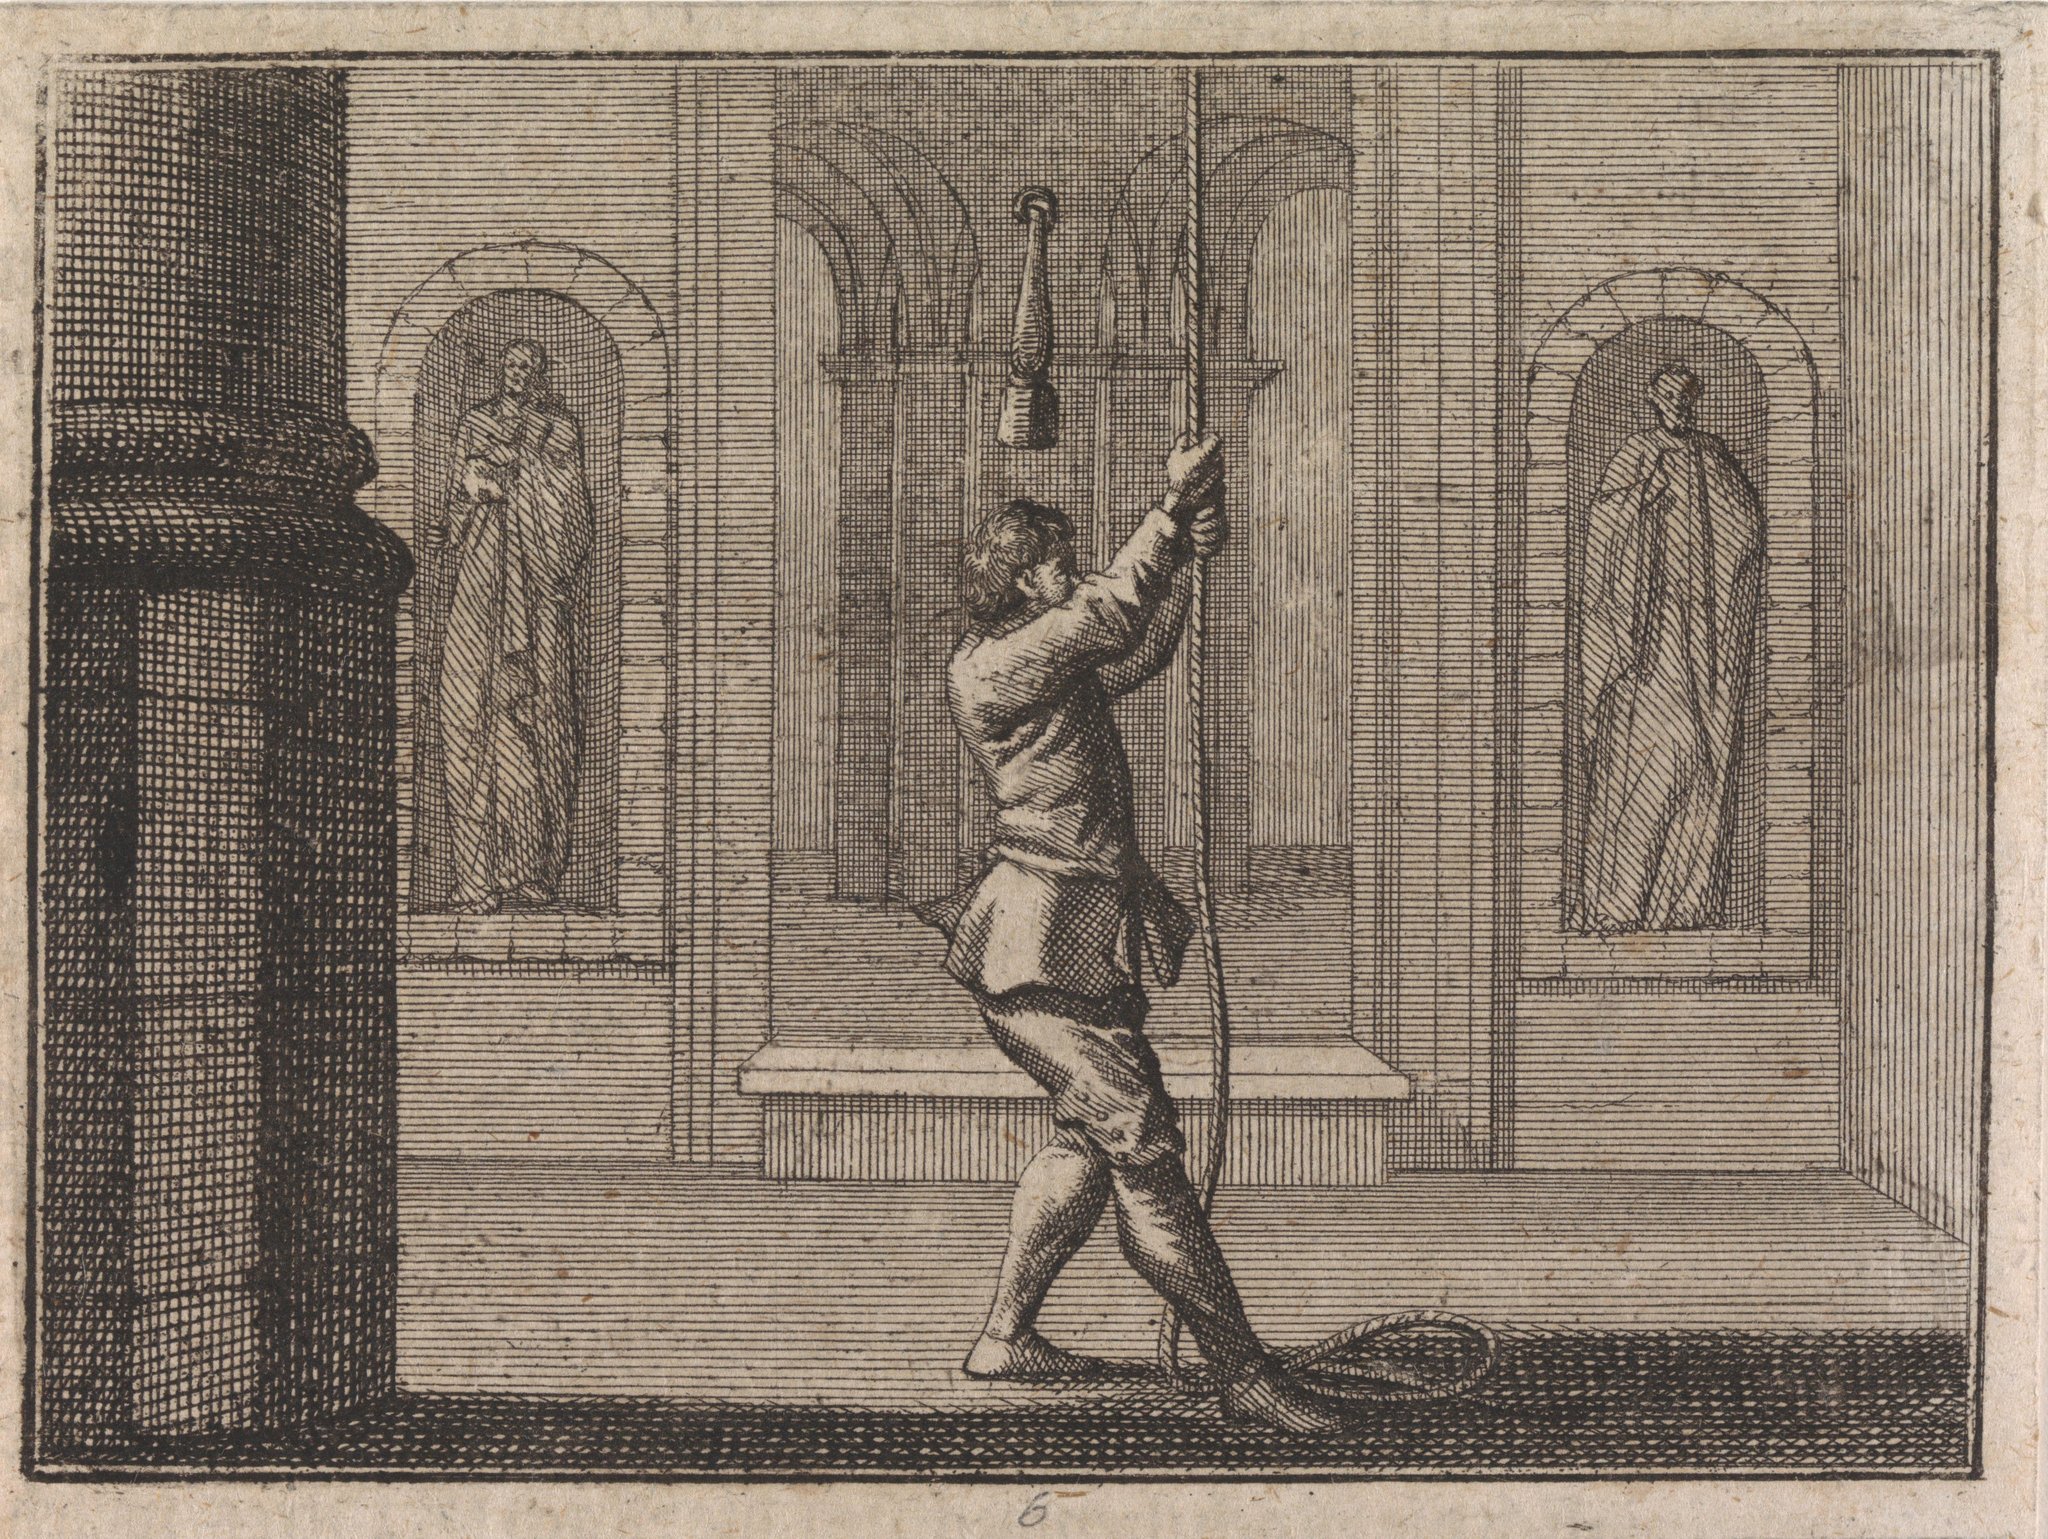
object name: book illustration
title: Manches Gut, thut kein gut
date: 1710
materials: paper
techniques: etching, letterpress printing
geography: nuremberg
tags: church bell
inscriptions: collector's mark: Lugt 2228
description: Illustratie uit: Abraham a Sancta Clara. Heilsames Gemisch Gemasch, das ist: Allerley seltsame und verwunderliche Geschichten (...). Neurenberg: Christoph Weigel, 1710, p. 51.